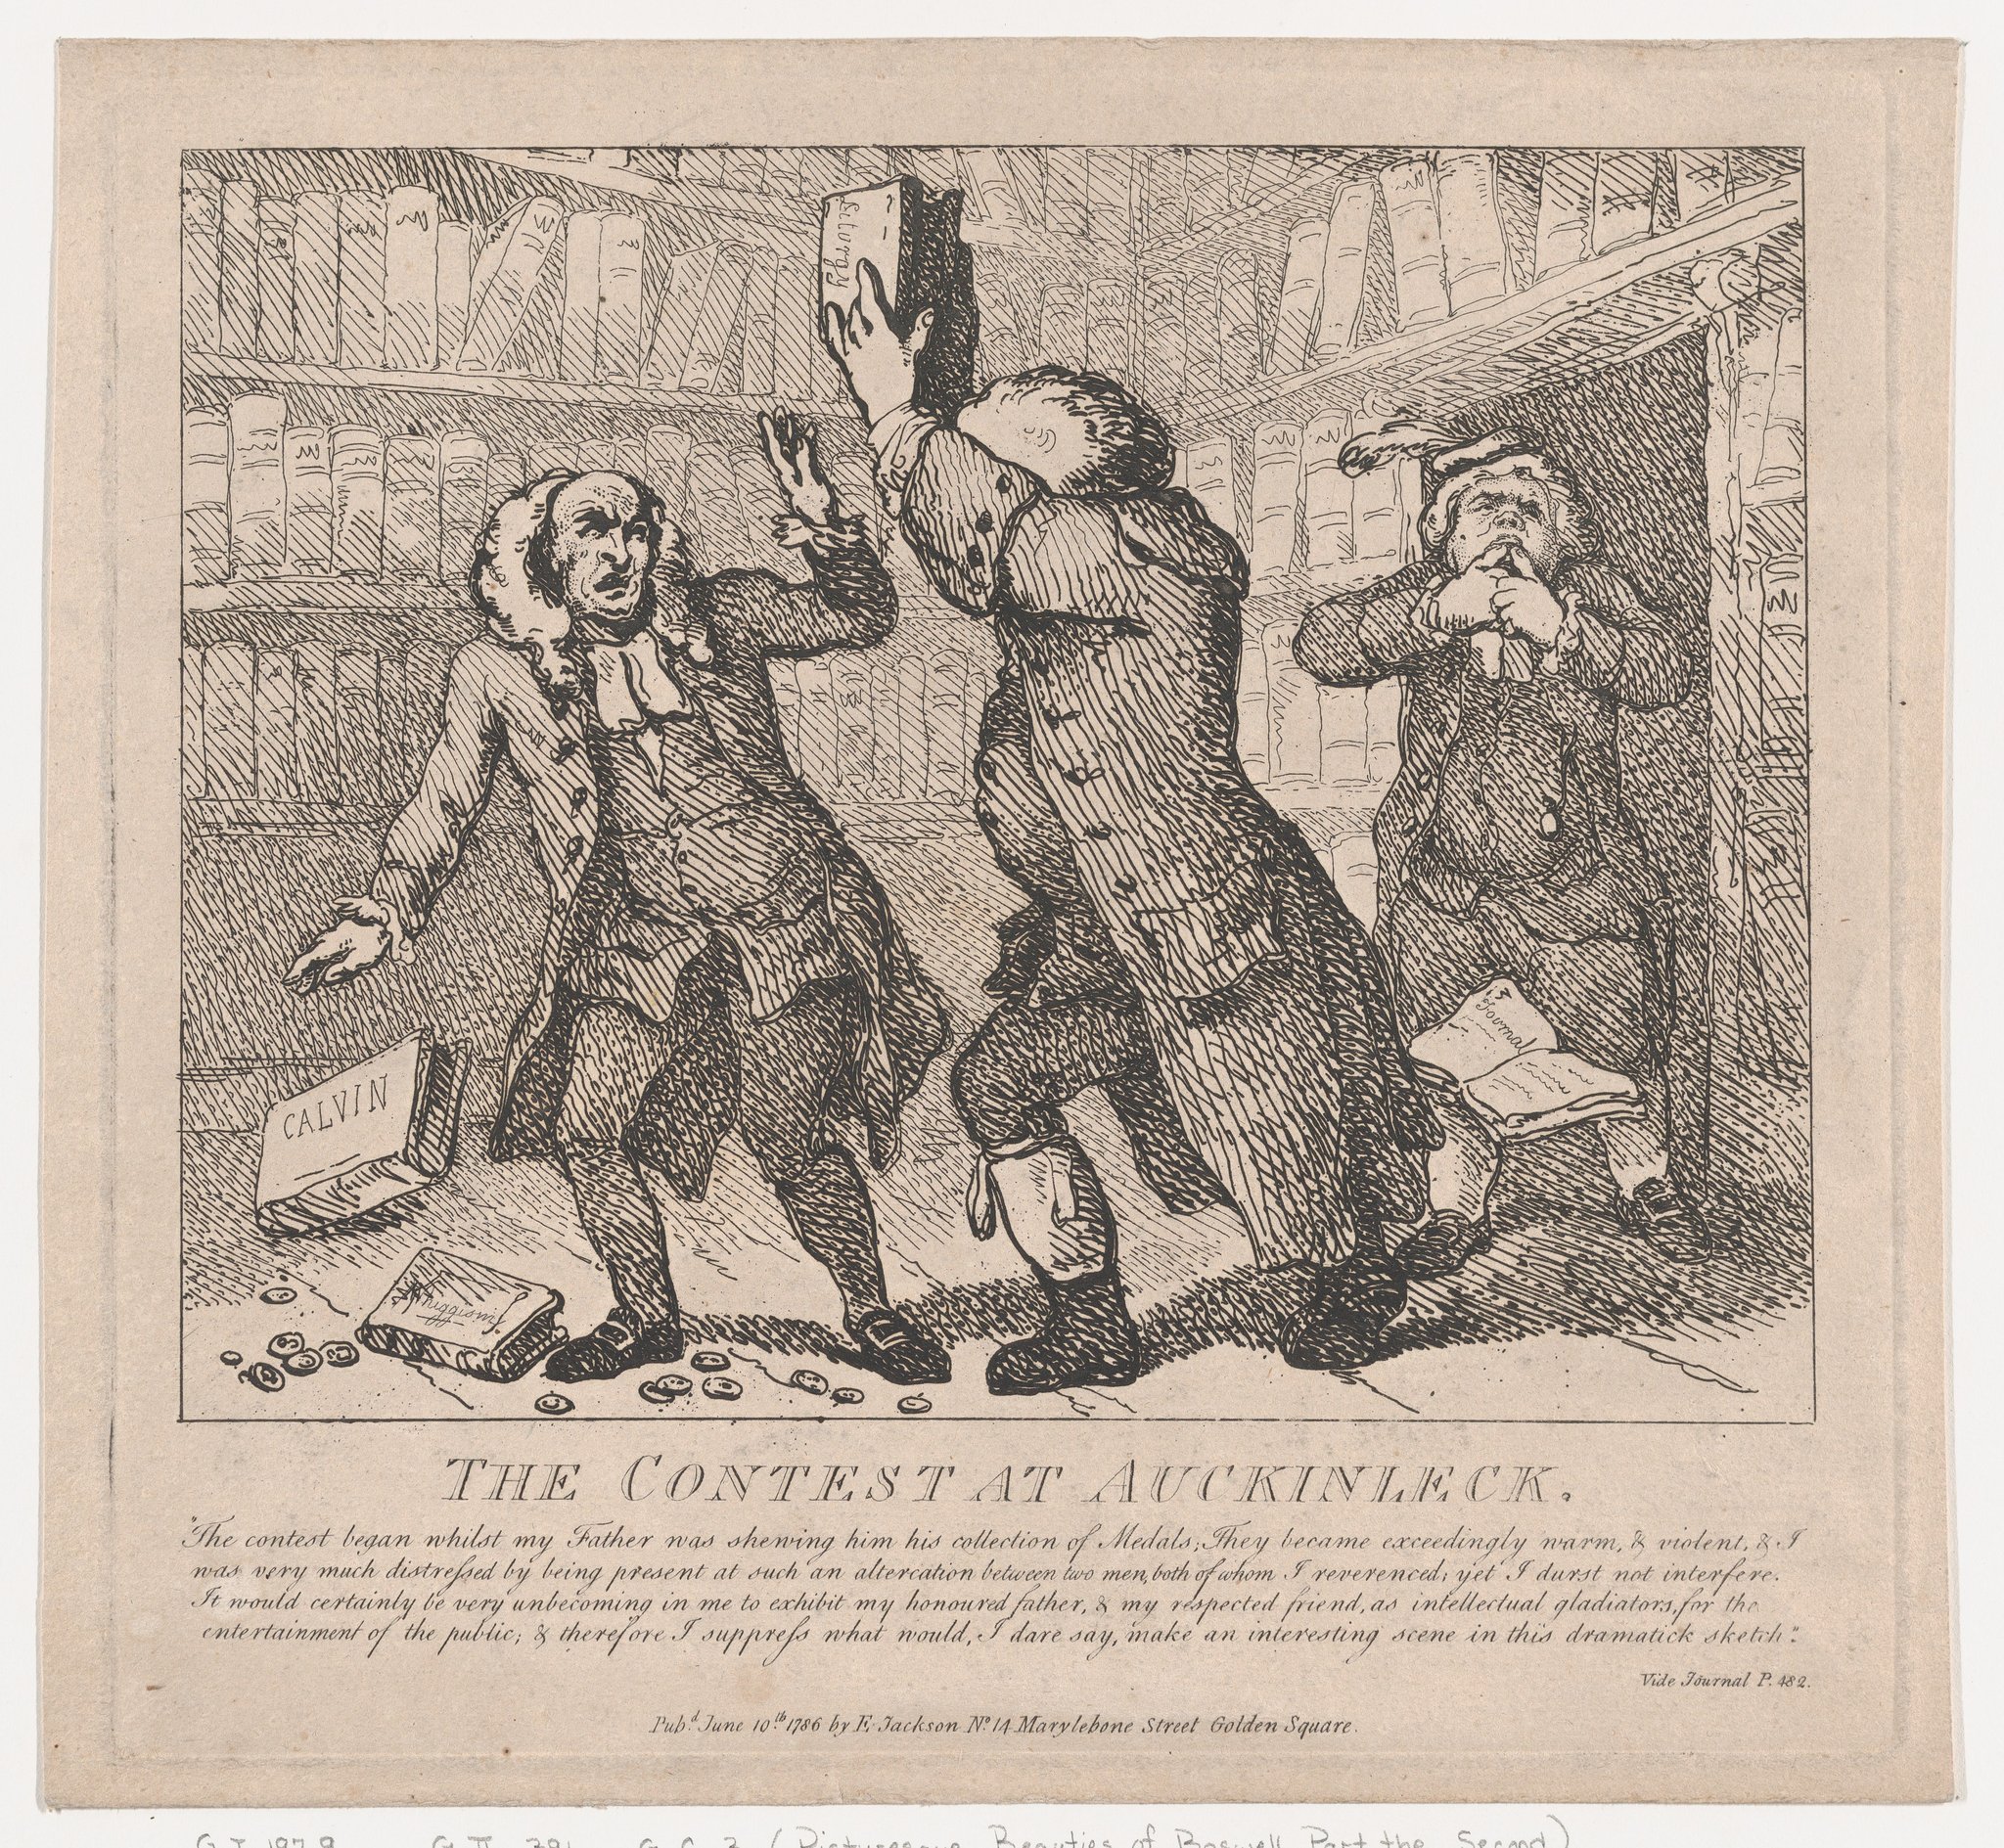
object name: print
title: The Contest at Auckinleck (Picturesque Beauties of Boswell, Part the Second)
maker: thomas rowlandson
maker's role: artist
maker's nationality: british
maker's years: 1757-1827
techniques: etching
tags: satire,libraries,men